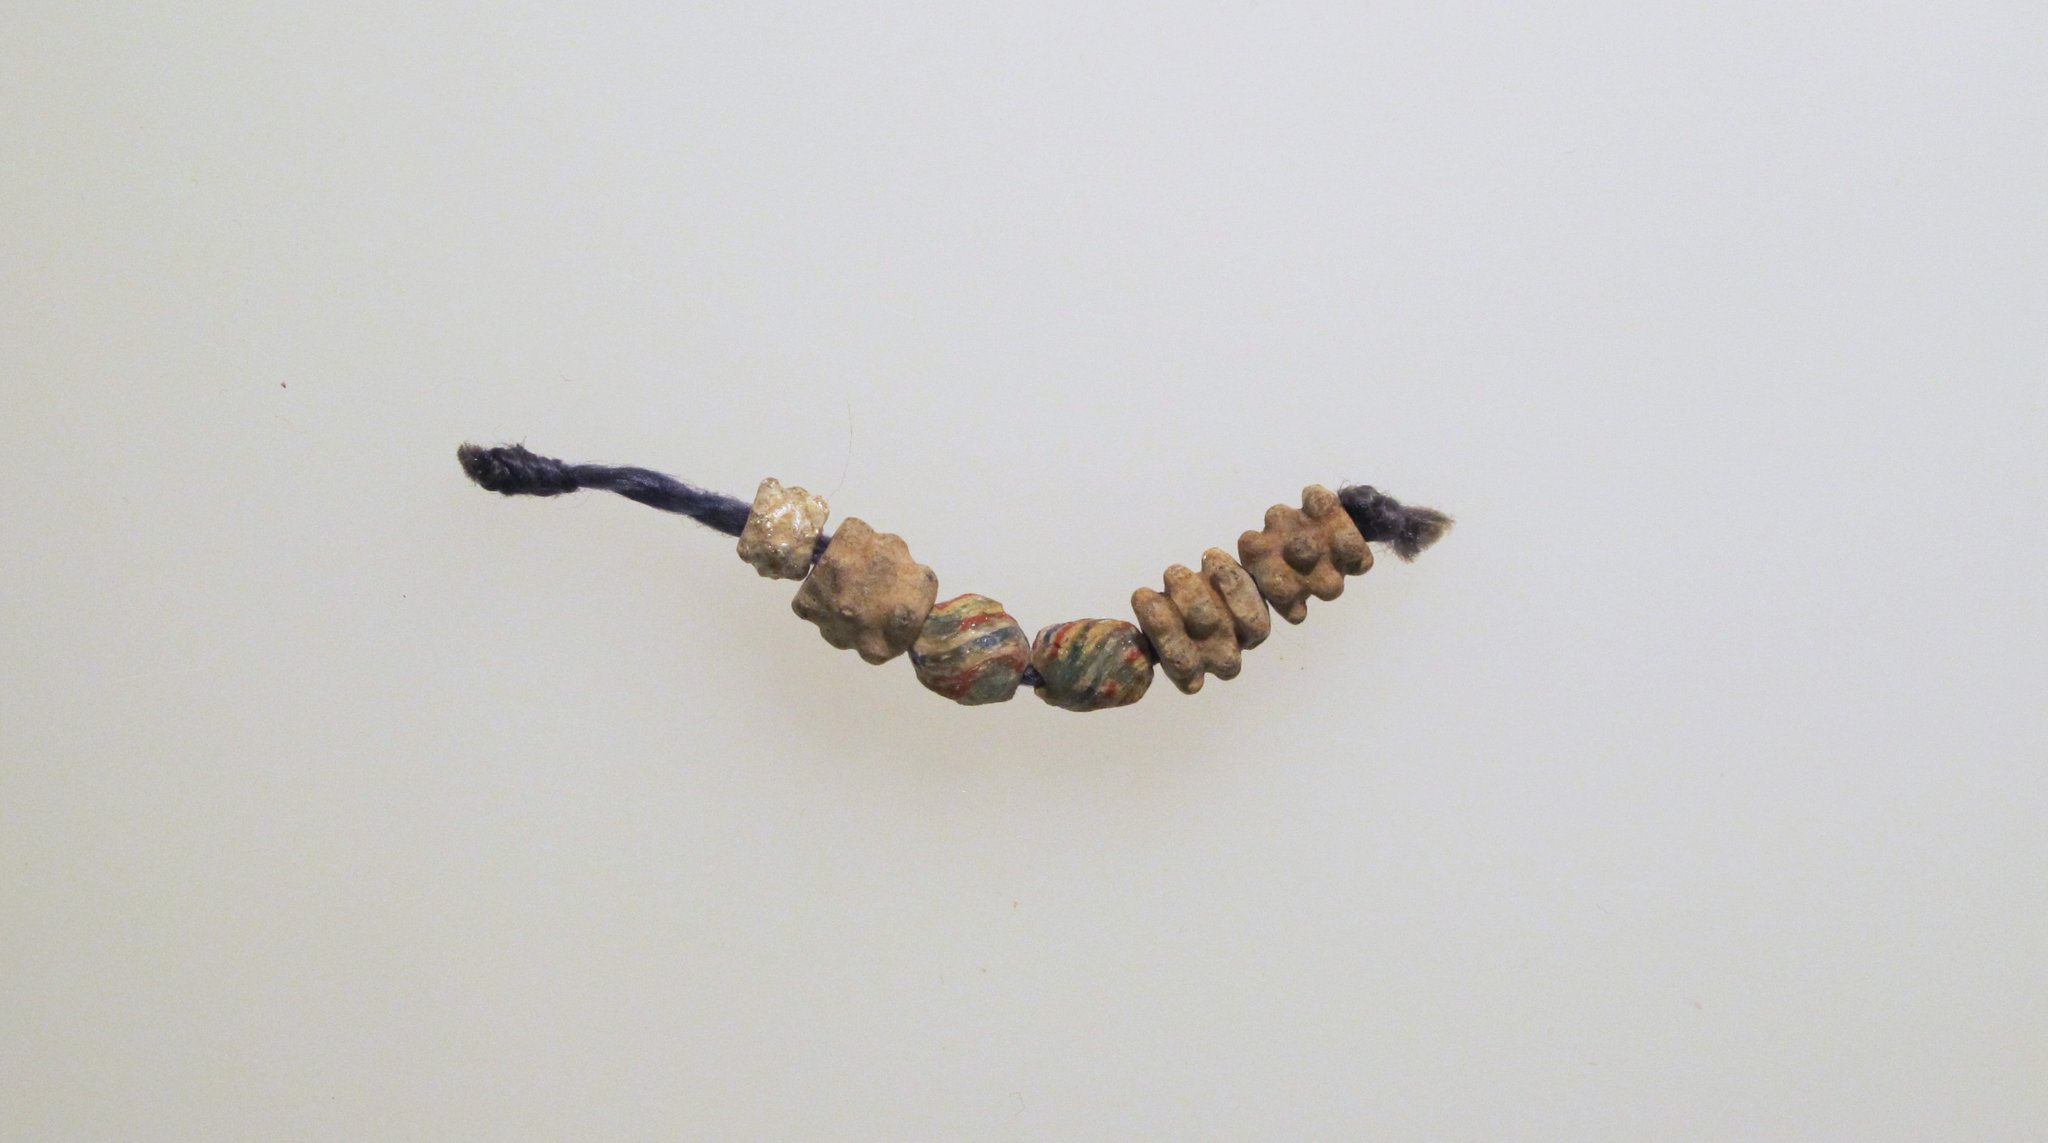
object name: bead, 6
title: Beads, 6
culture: roman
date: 670 BCE-330 CE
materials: glass